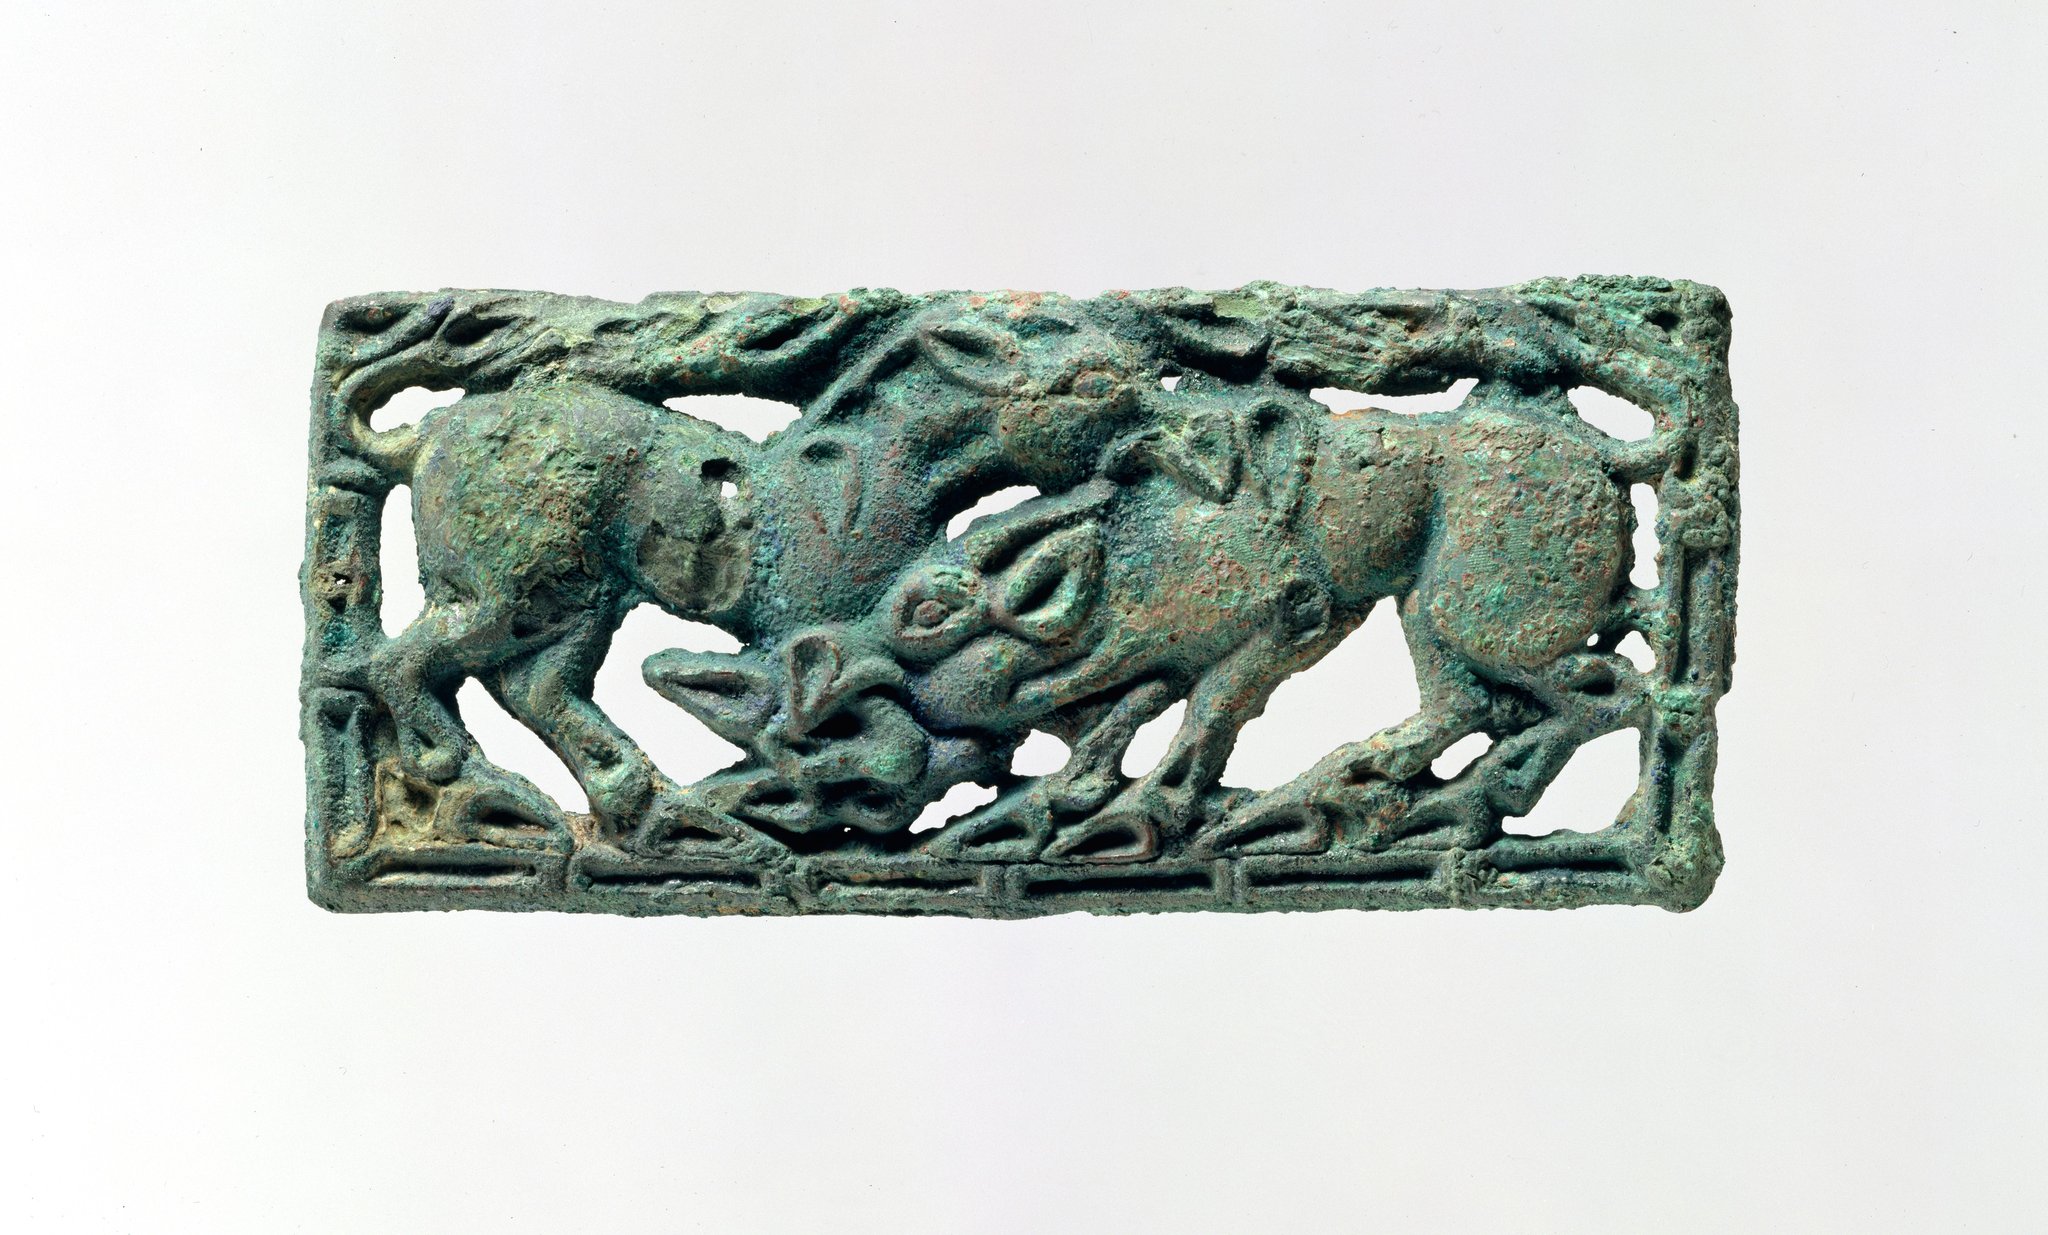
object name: belt plaque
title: Belt Plaque with Fighting Stallions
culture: siberian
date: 200-101 BCE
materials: bronze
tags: horses